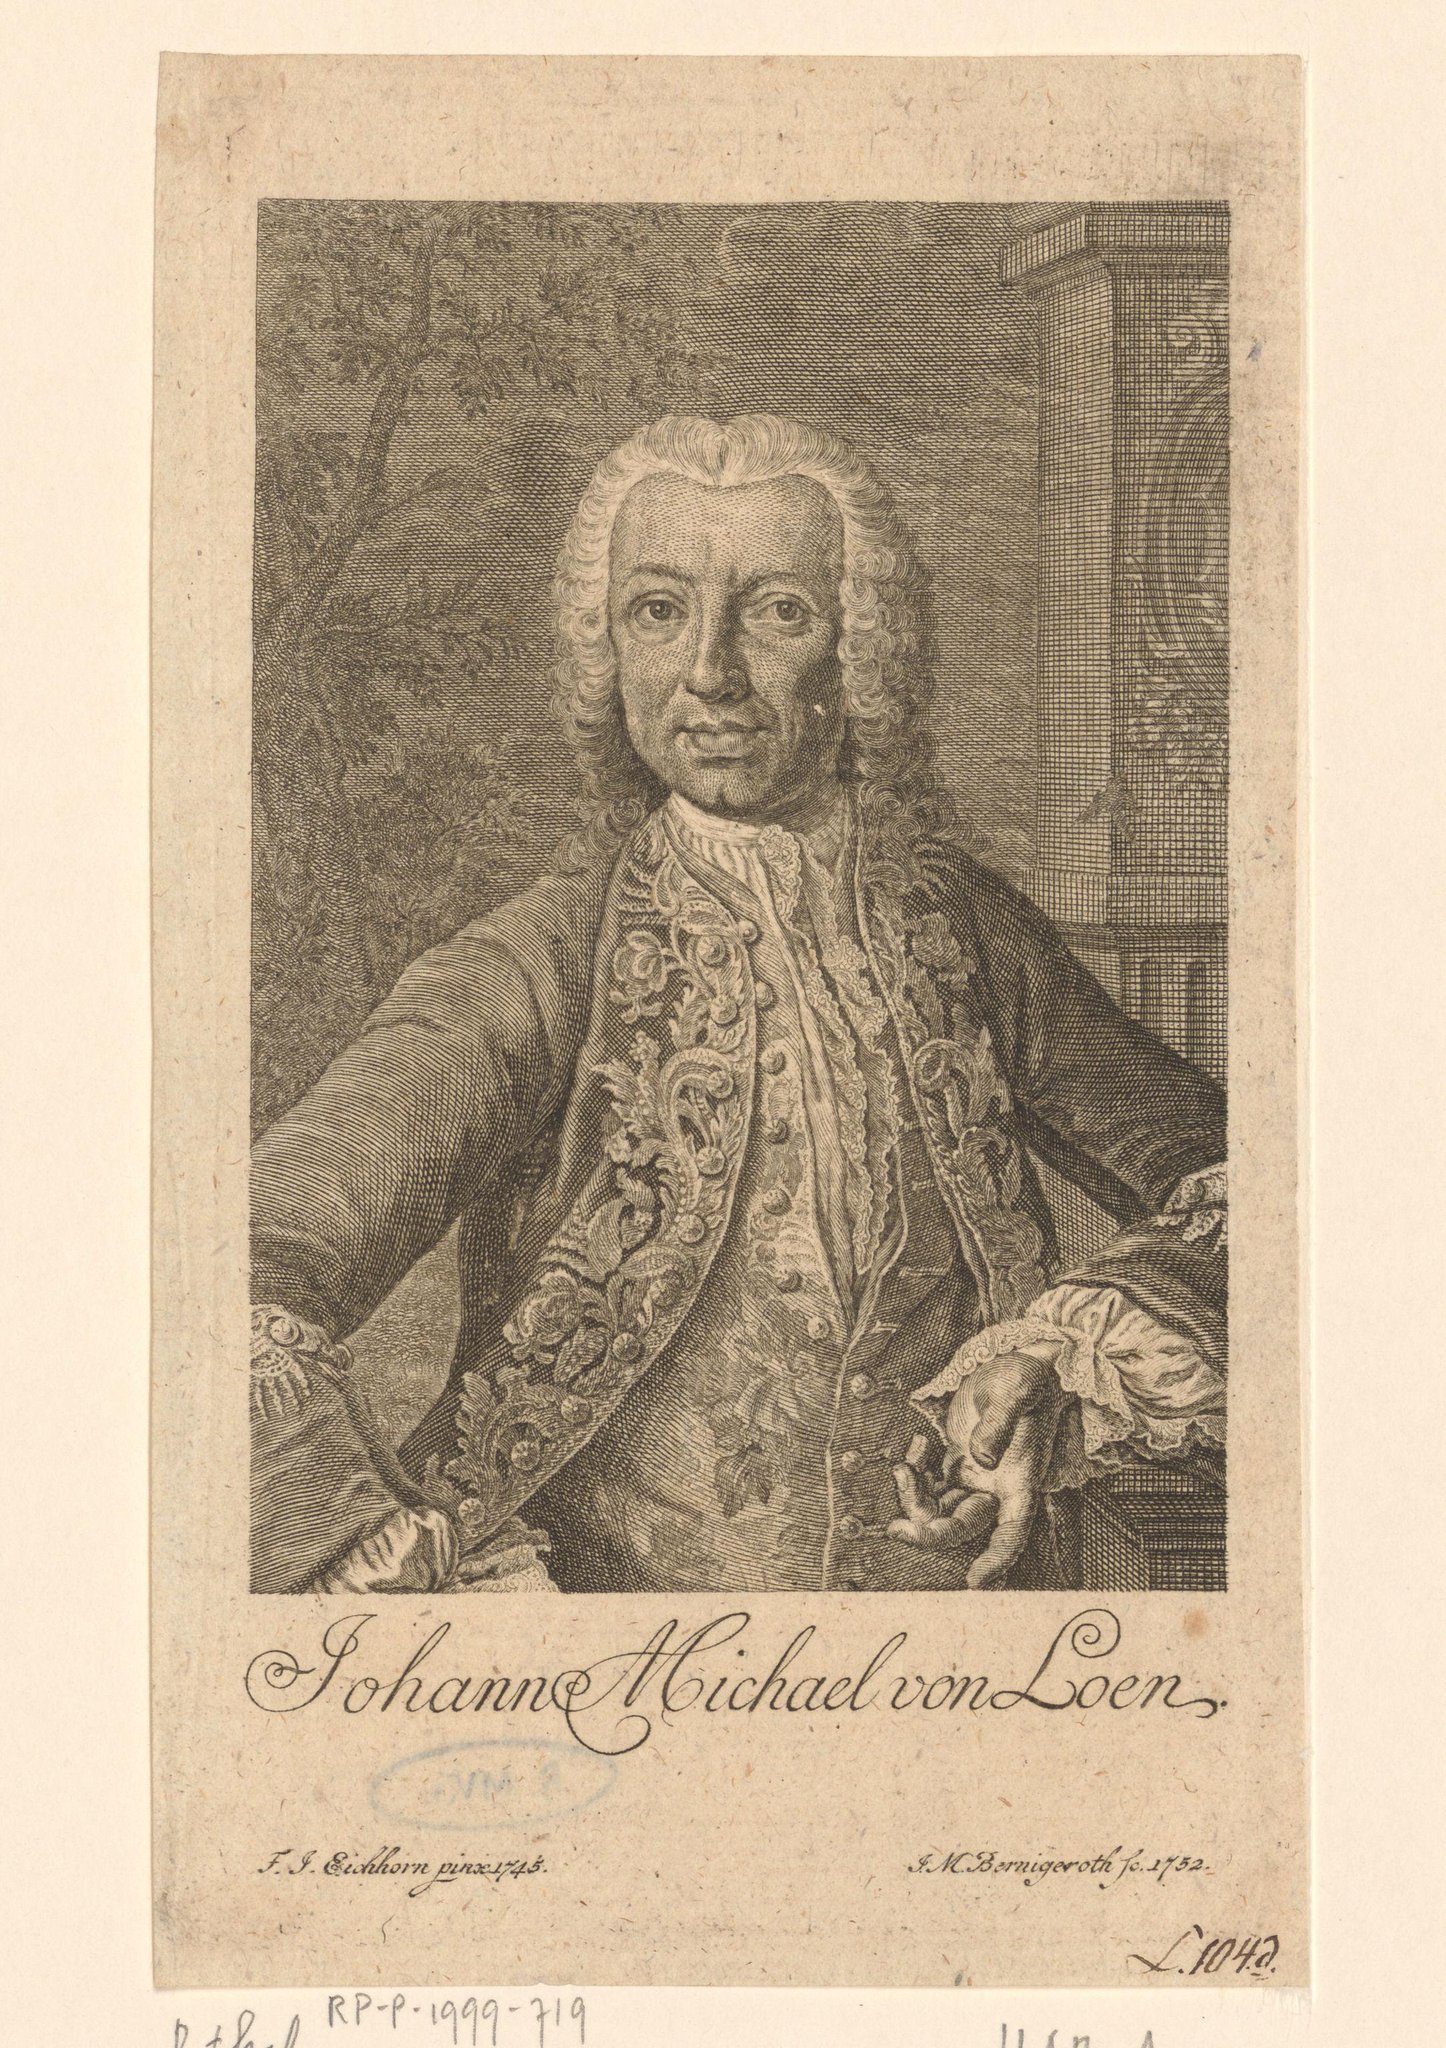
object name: print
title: Portret van Johann Michael von Loën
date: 1752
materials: paper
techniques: engraving, etching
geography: germany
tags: historical persons, portrait of a writer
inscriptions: inscription: ‘L. 104 d.’, collector's mark: Lugt 2228